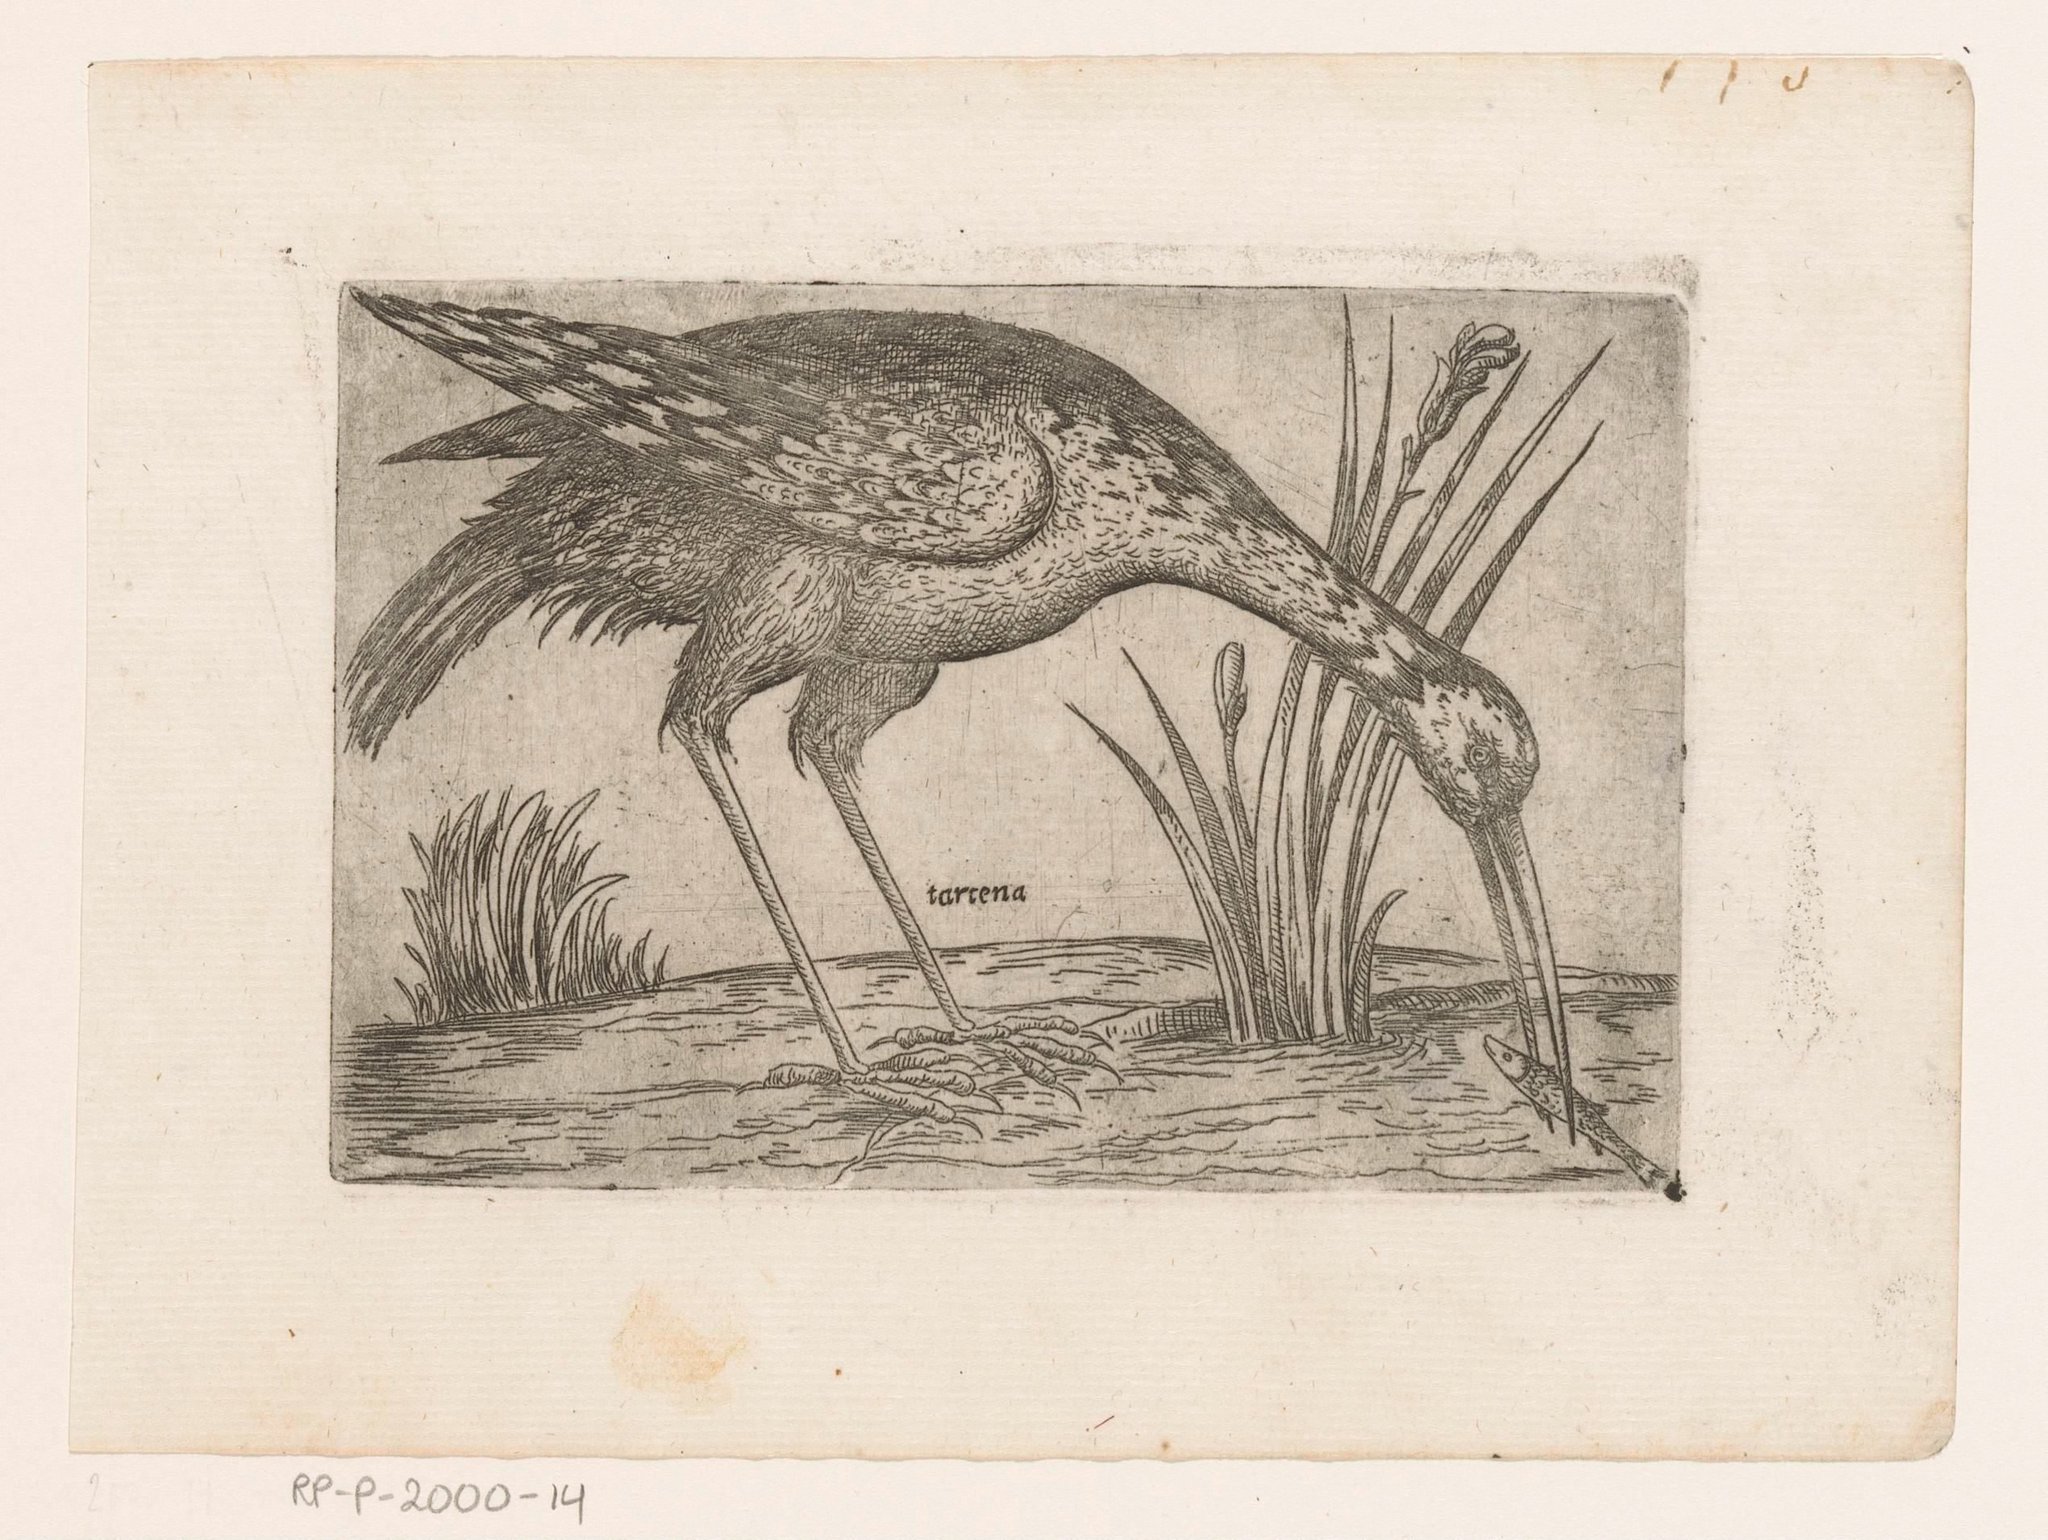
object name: print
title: Tartena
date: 1580-1590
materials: paper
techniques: etching, intaglio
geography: italy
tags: shore-birds and wading-birds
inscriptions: collector's mark: Lugt 2228, collector's mark: Lugt 2760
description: Deze prent maakt deel uit van een reeks prenten van vogels.